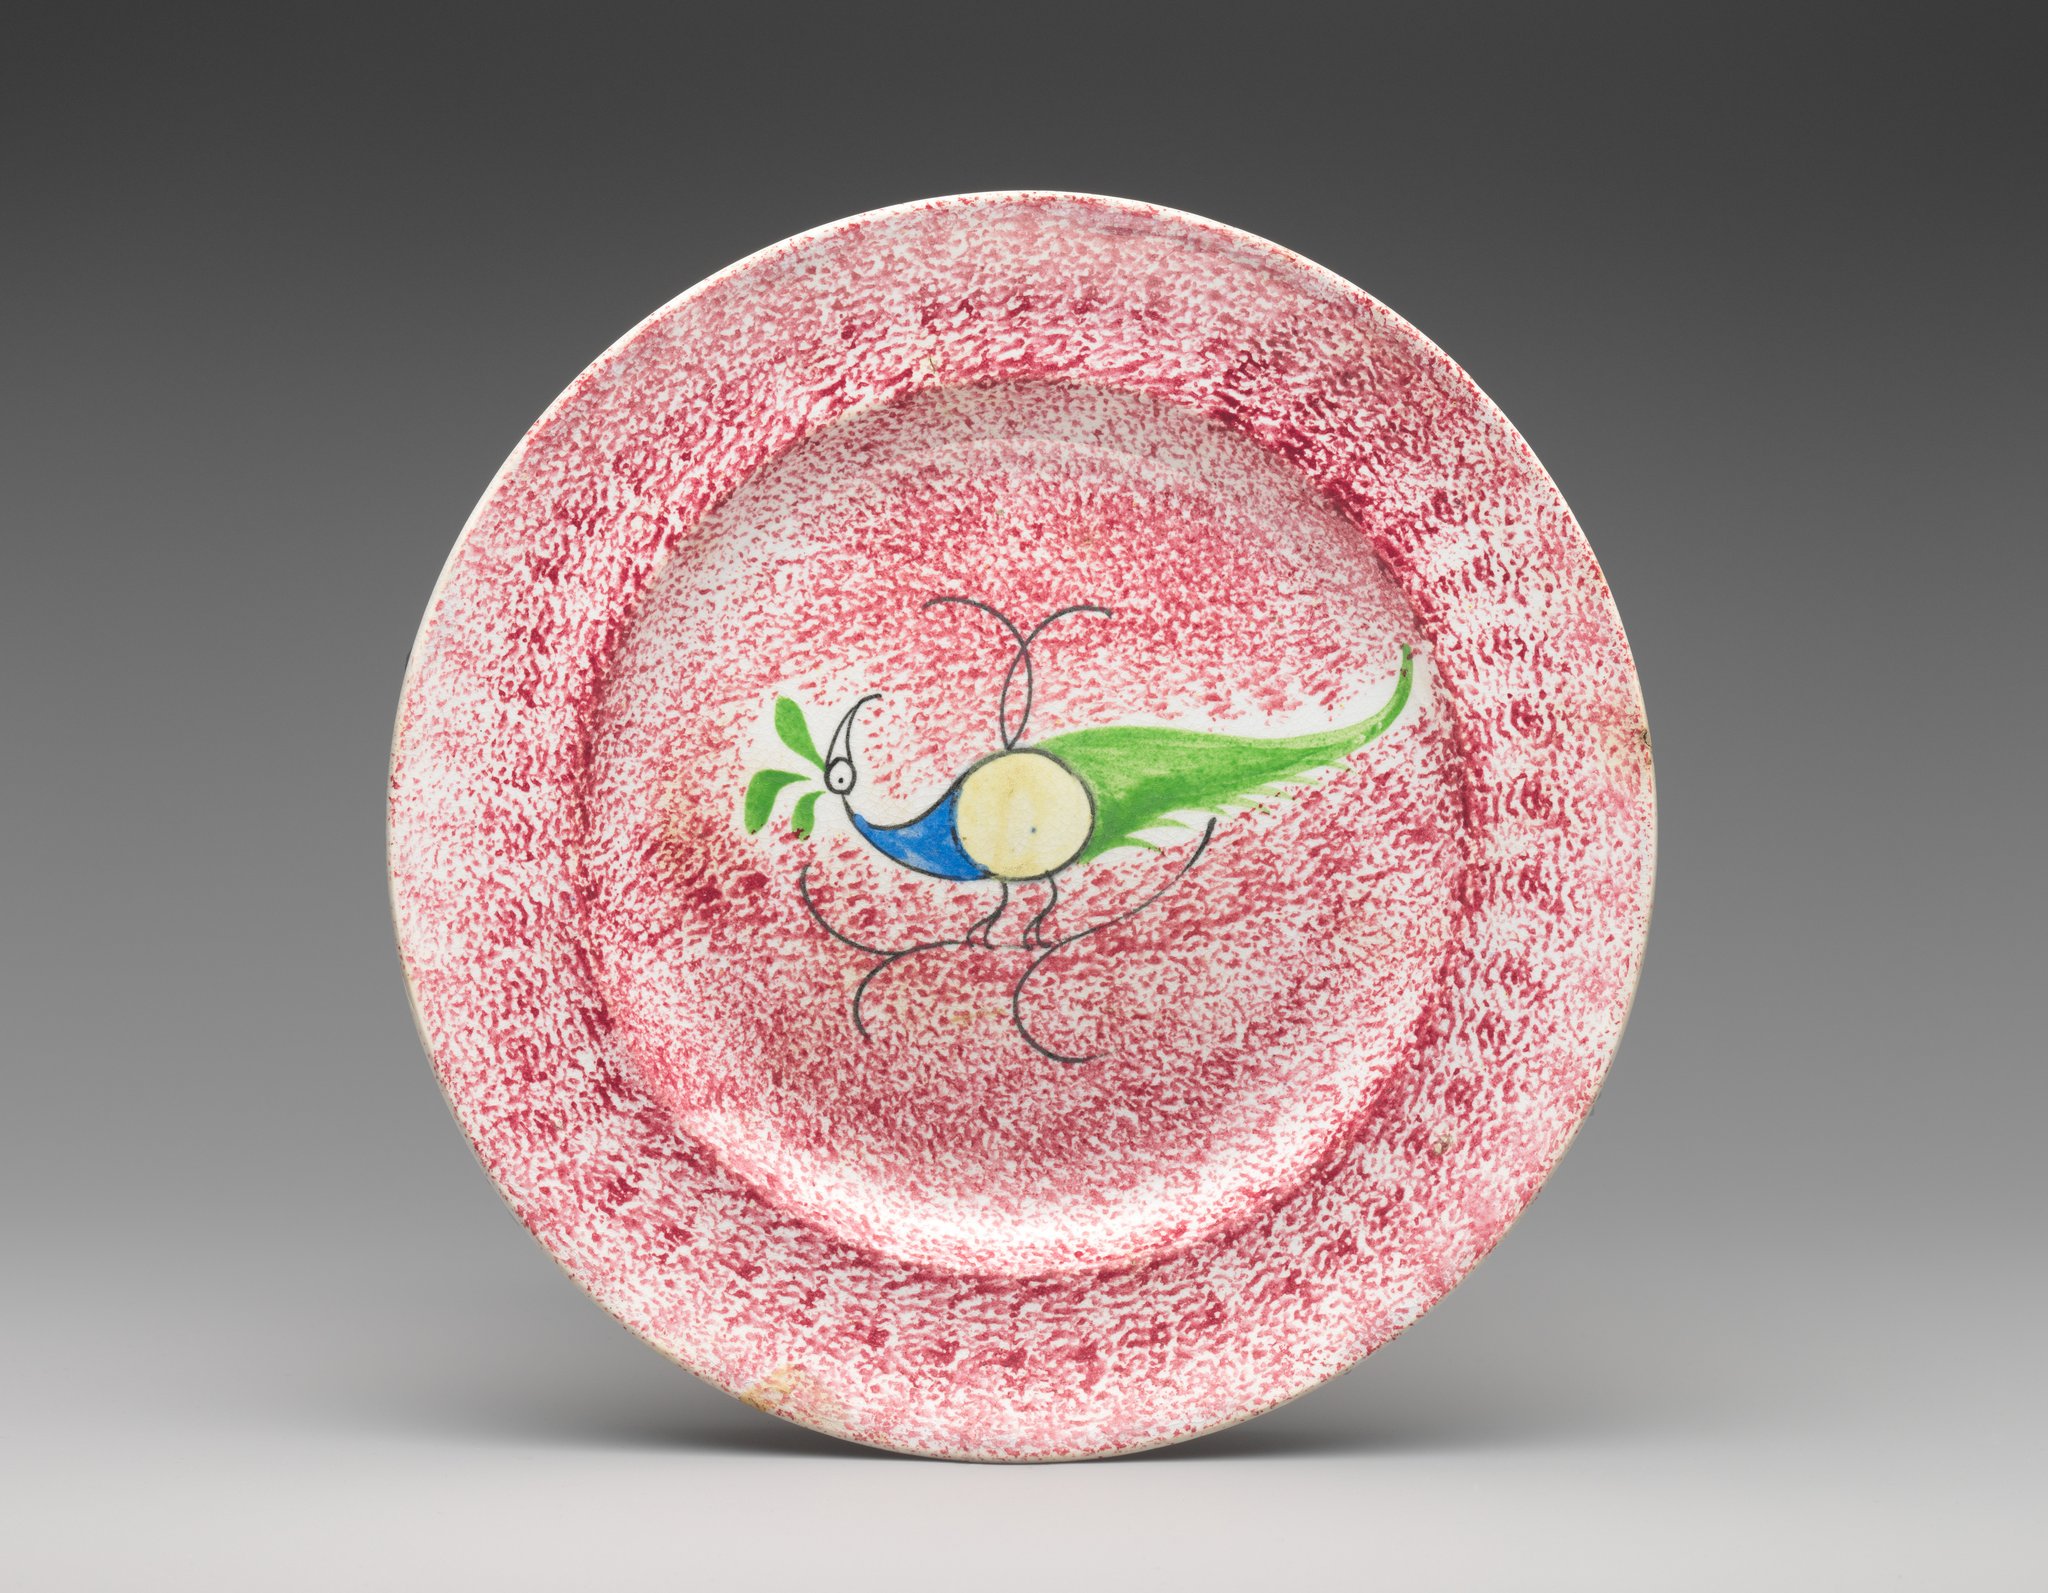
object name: plate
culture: british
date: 1800-1830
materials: earthenware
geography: england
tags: birds